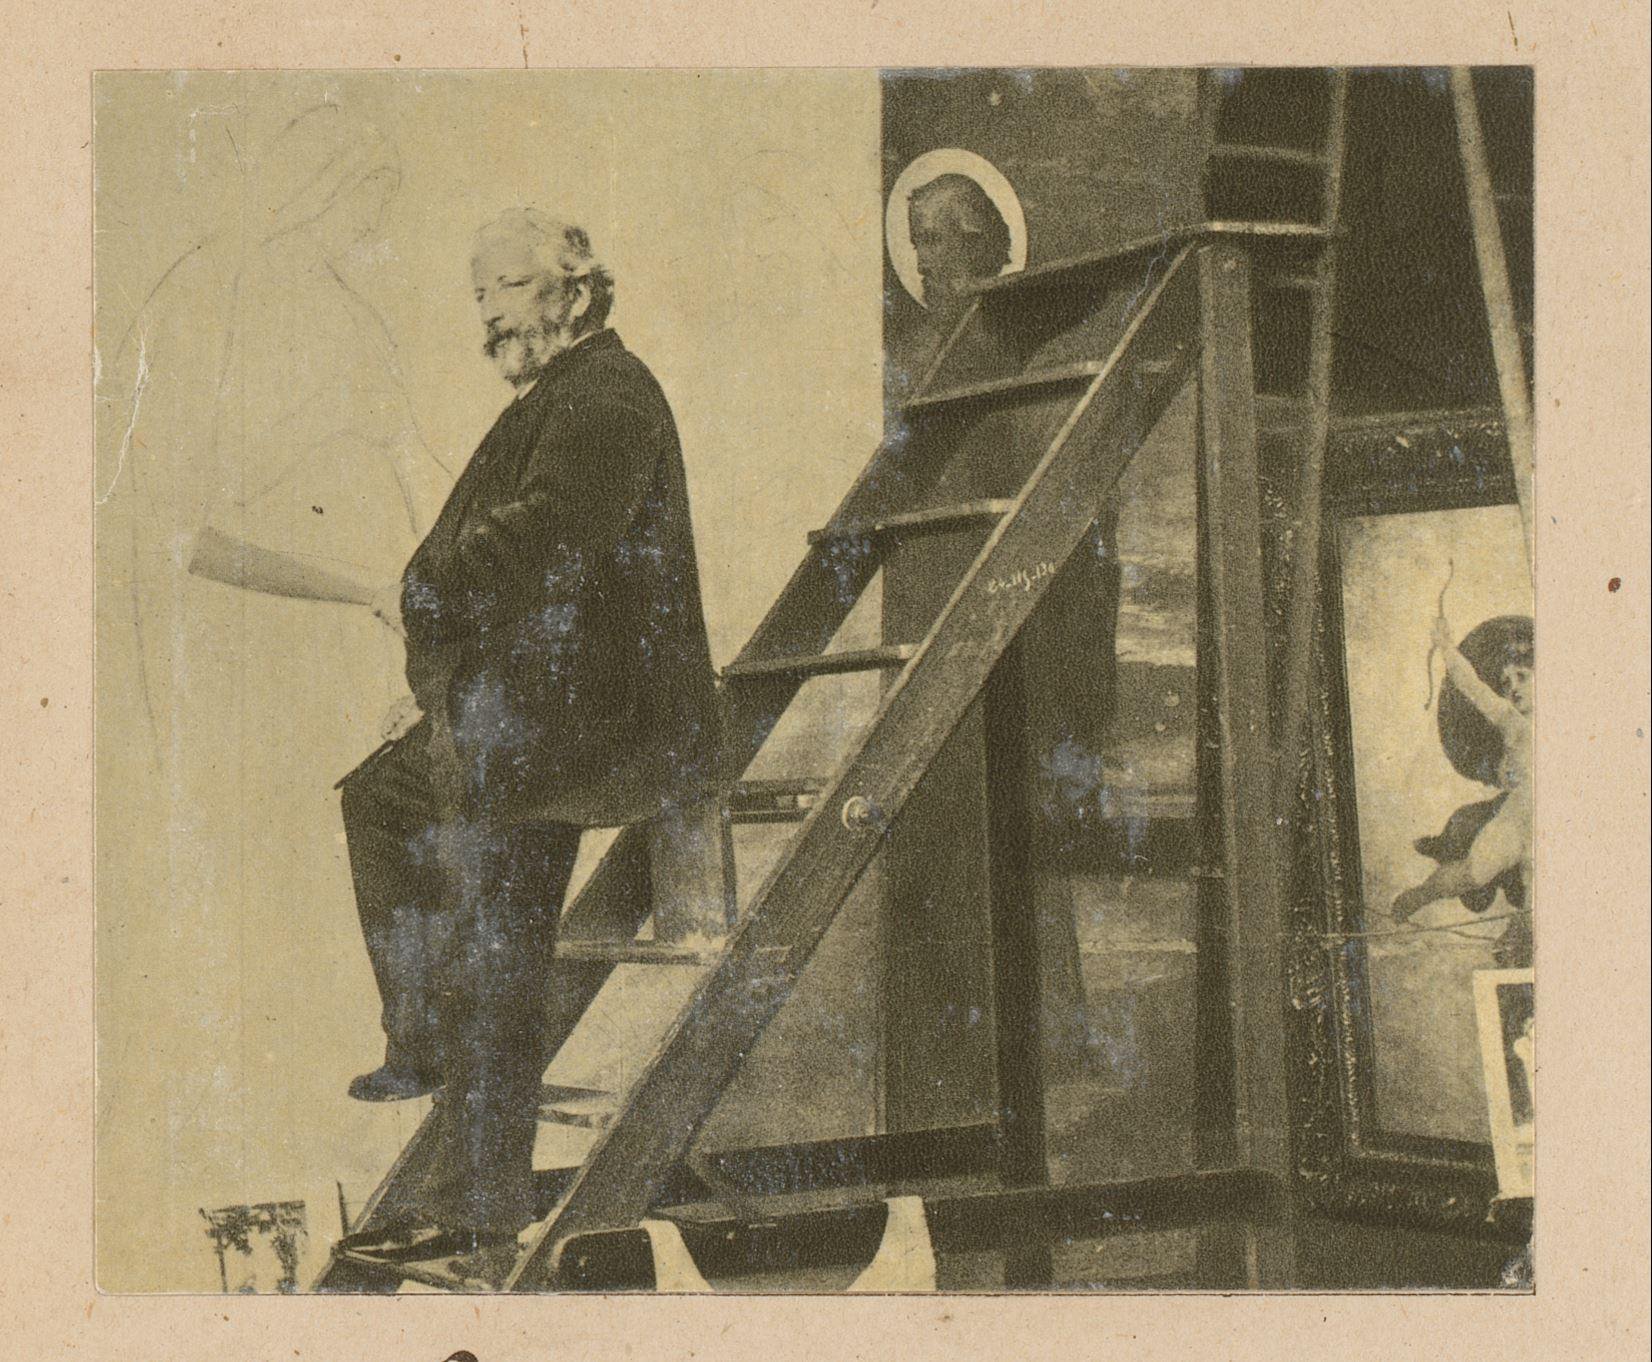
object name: photograph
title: Portret van William Bouguereau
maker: Anonymous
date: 1900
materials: paper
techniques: rotogravure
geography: france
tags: painter, historical persons, artist (in general), france